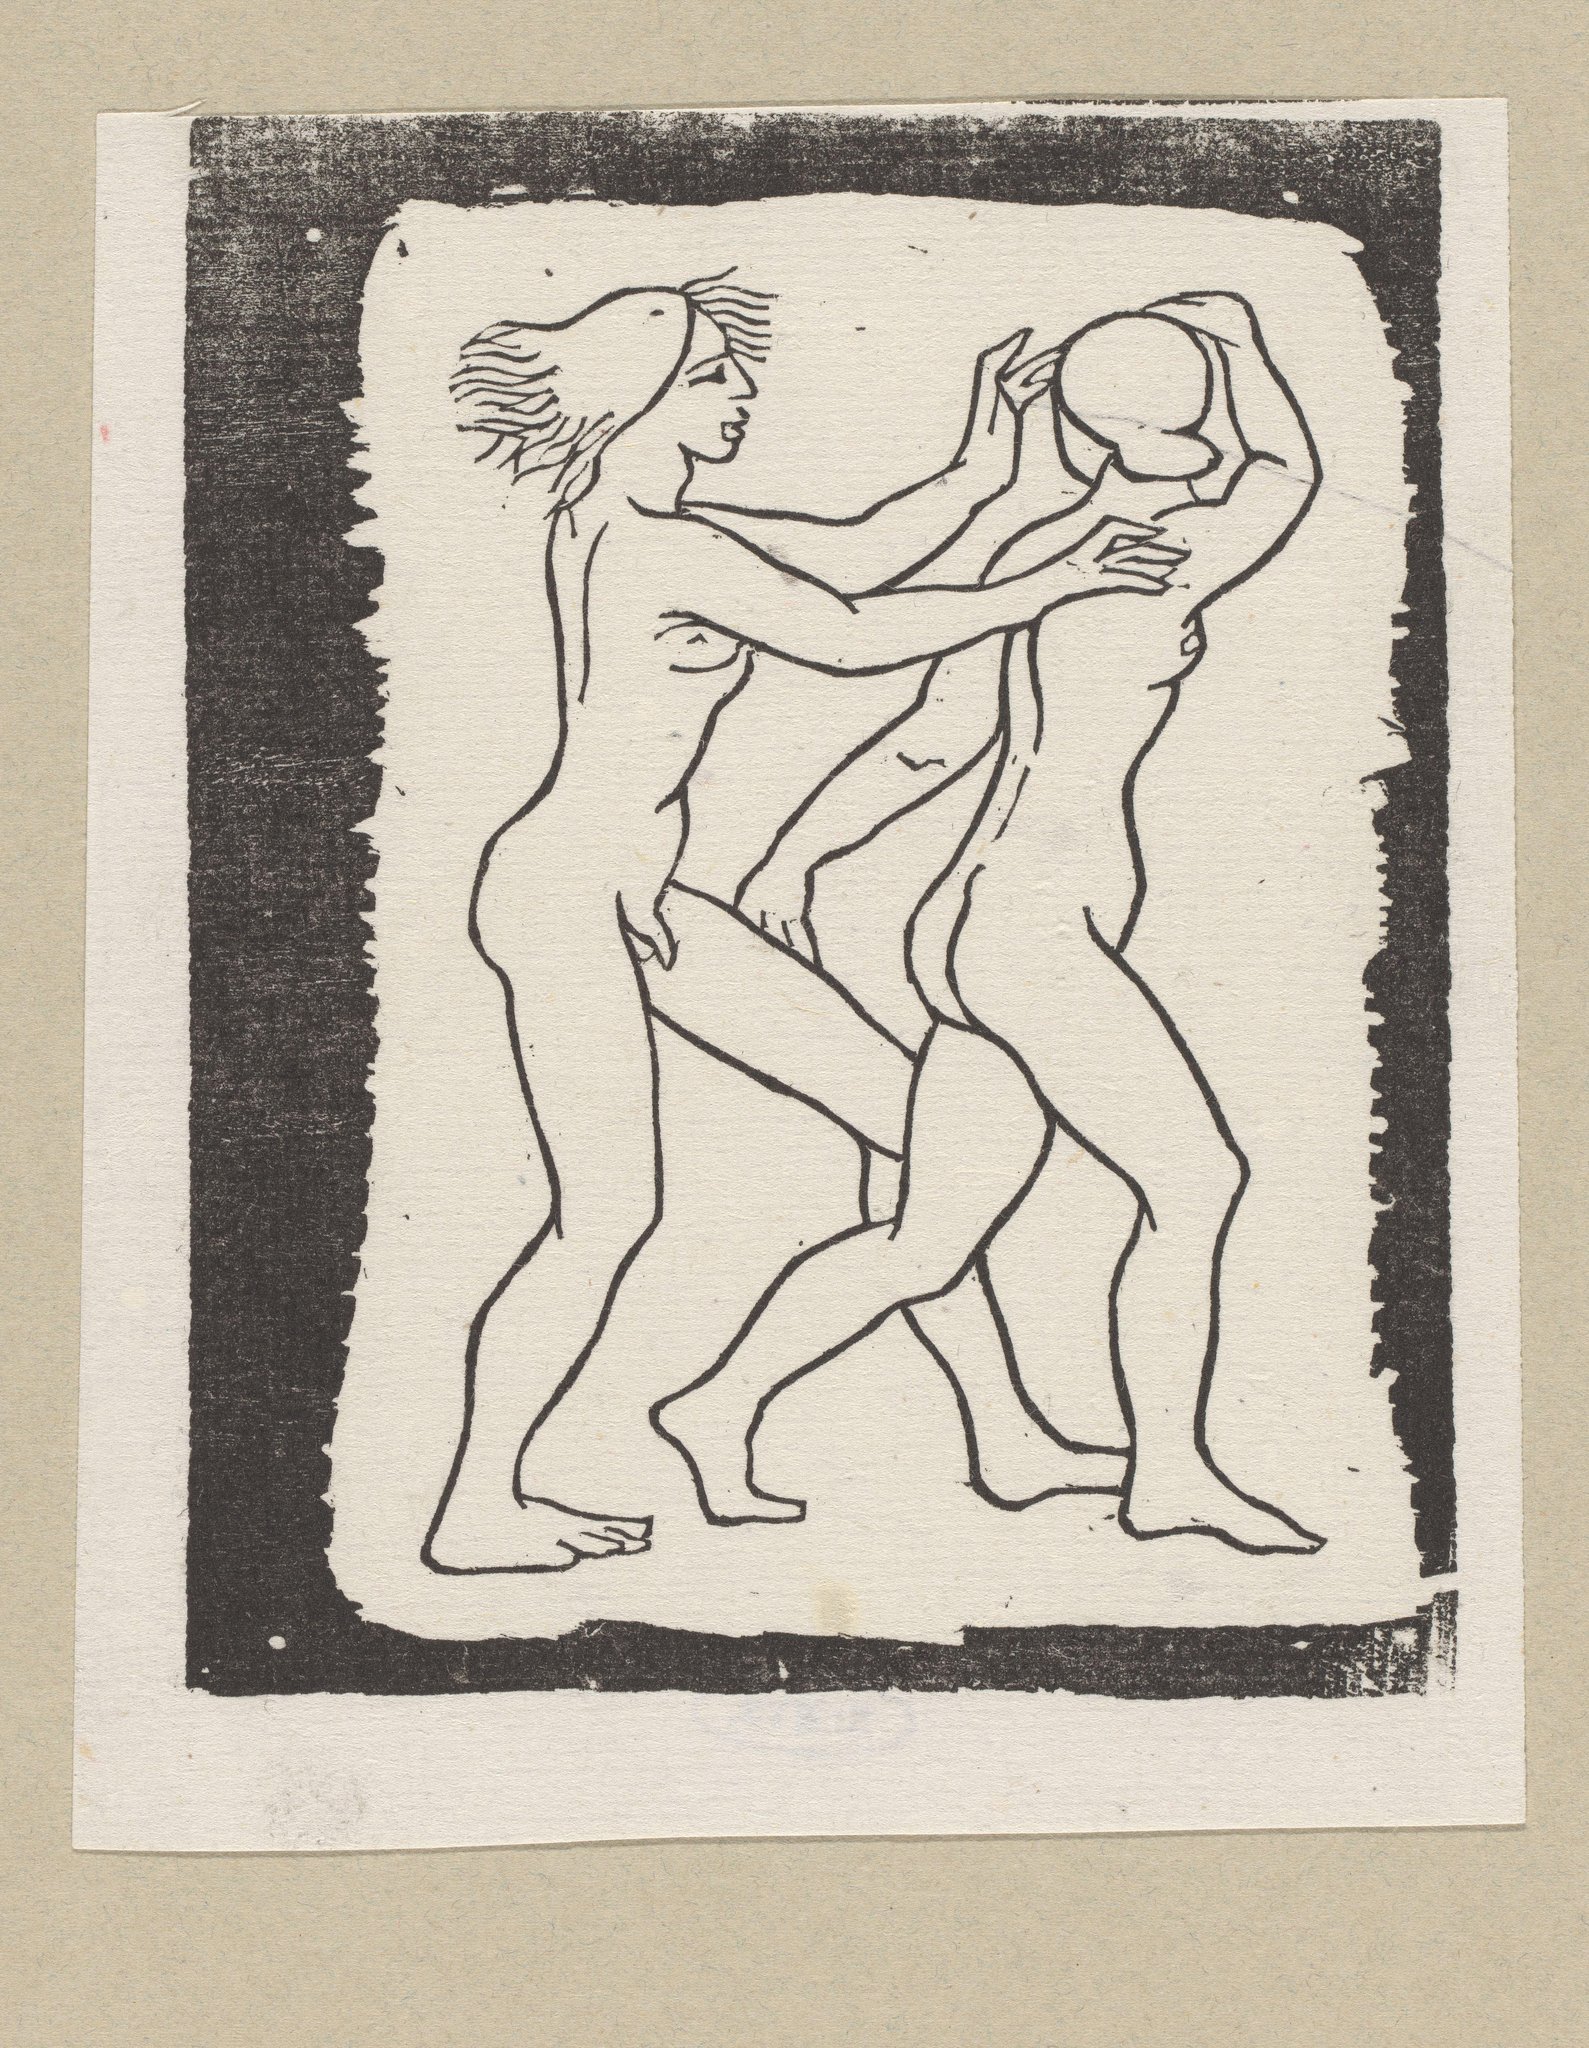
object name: print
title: Daphnis poursuivant Chloé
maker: aristide maillol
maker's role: draughtsman, painter, print maker, sculptor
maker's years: 1861-1944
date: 1937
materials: paper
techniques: woodcut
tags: catch (~ running game), daphnis (in greek mythology a shepherd who invented pastoral poetry, chloe, couple of lovers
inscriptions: collector's mark: Lugt 2228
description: Latere staat van deze prent gebruikt in: Longus. Les Pastorales de Longus ou Daphnis & Chloé. Parijs: Frères Gonin, 1935, p. 91.